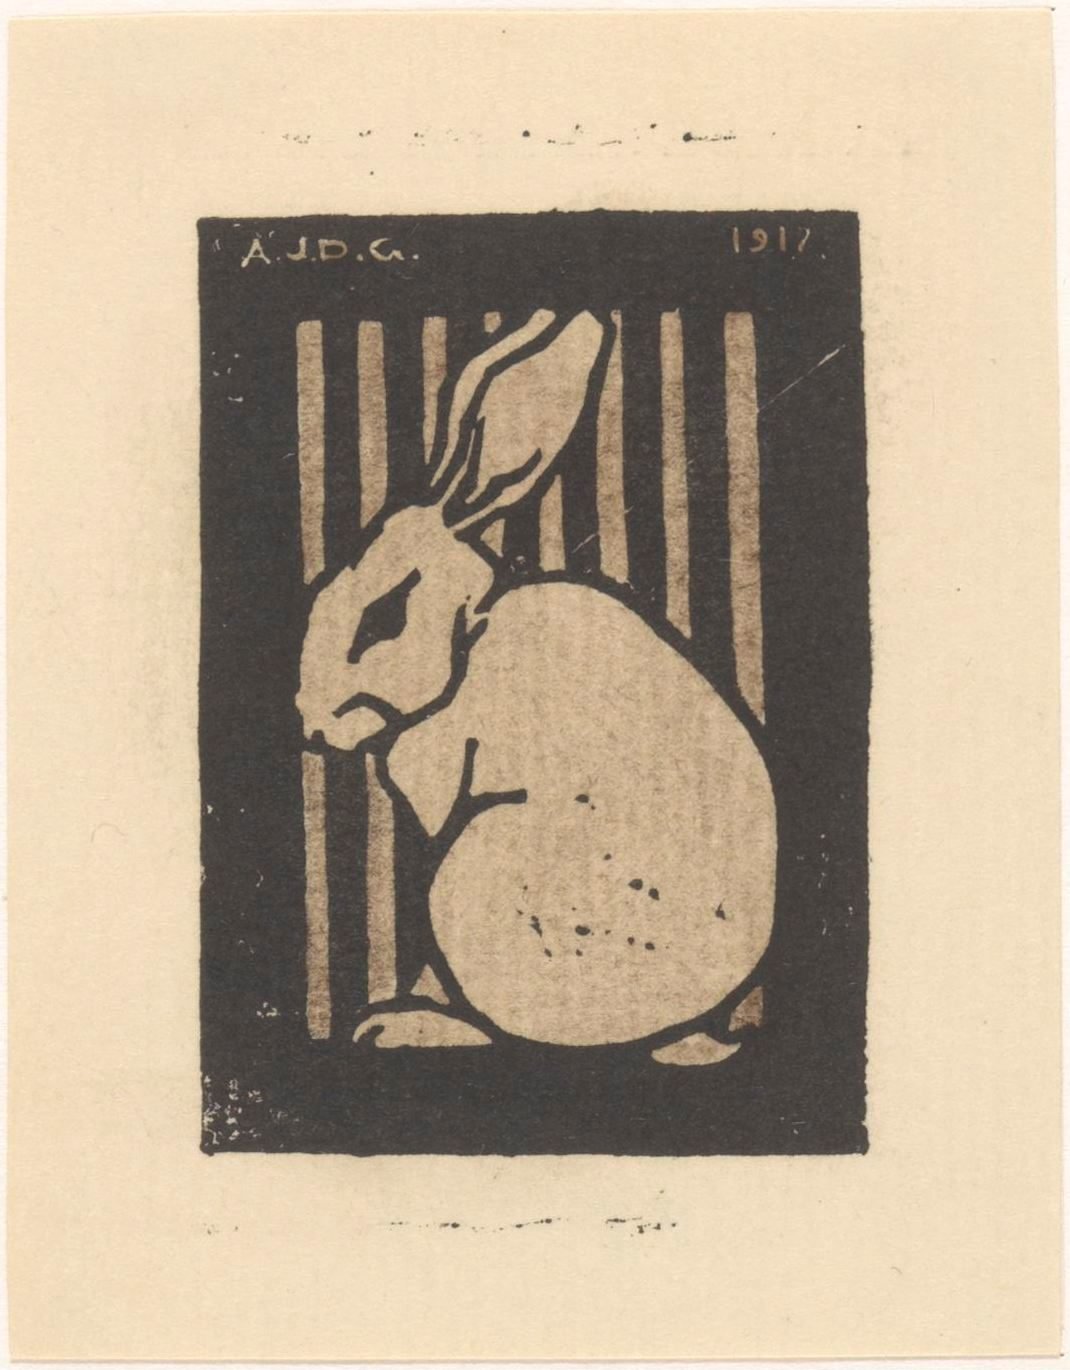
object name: print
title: Zittend konijn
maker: julie de graag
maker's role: draughtsman, print maker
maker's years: 1877-1924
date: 1917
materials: chalk, paper, pencil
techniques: hand coloring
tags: rodents: rabbit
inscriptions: collector's mark: Lugt 2228